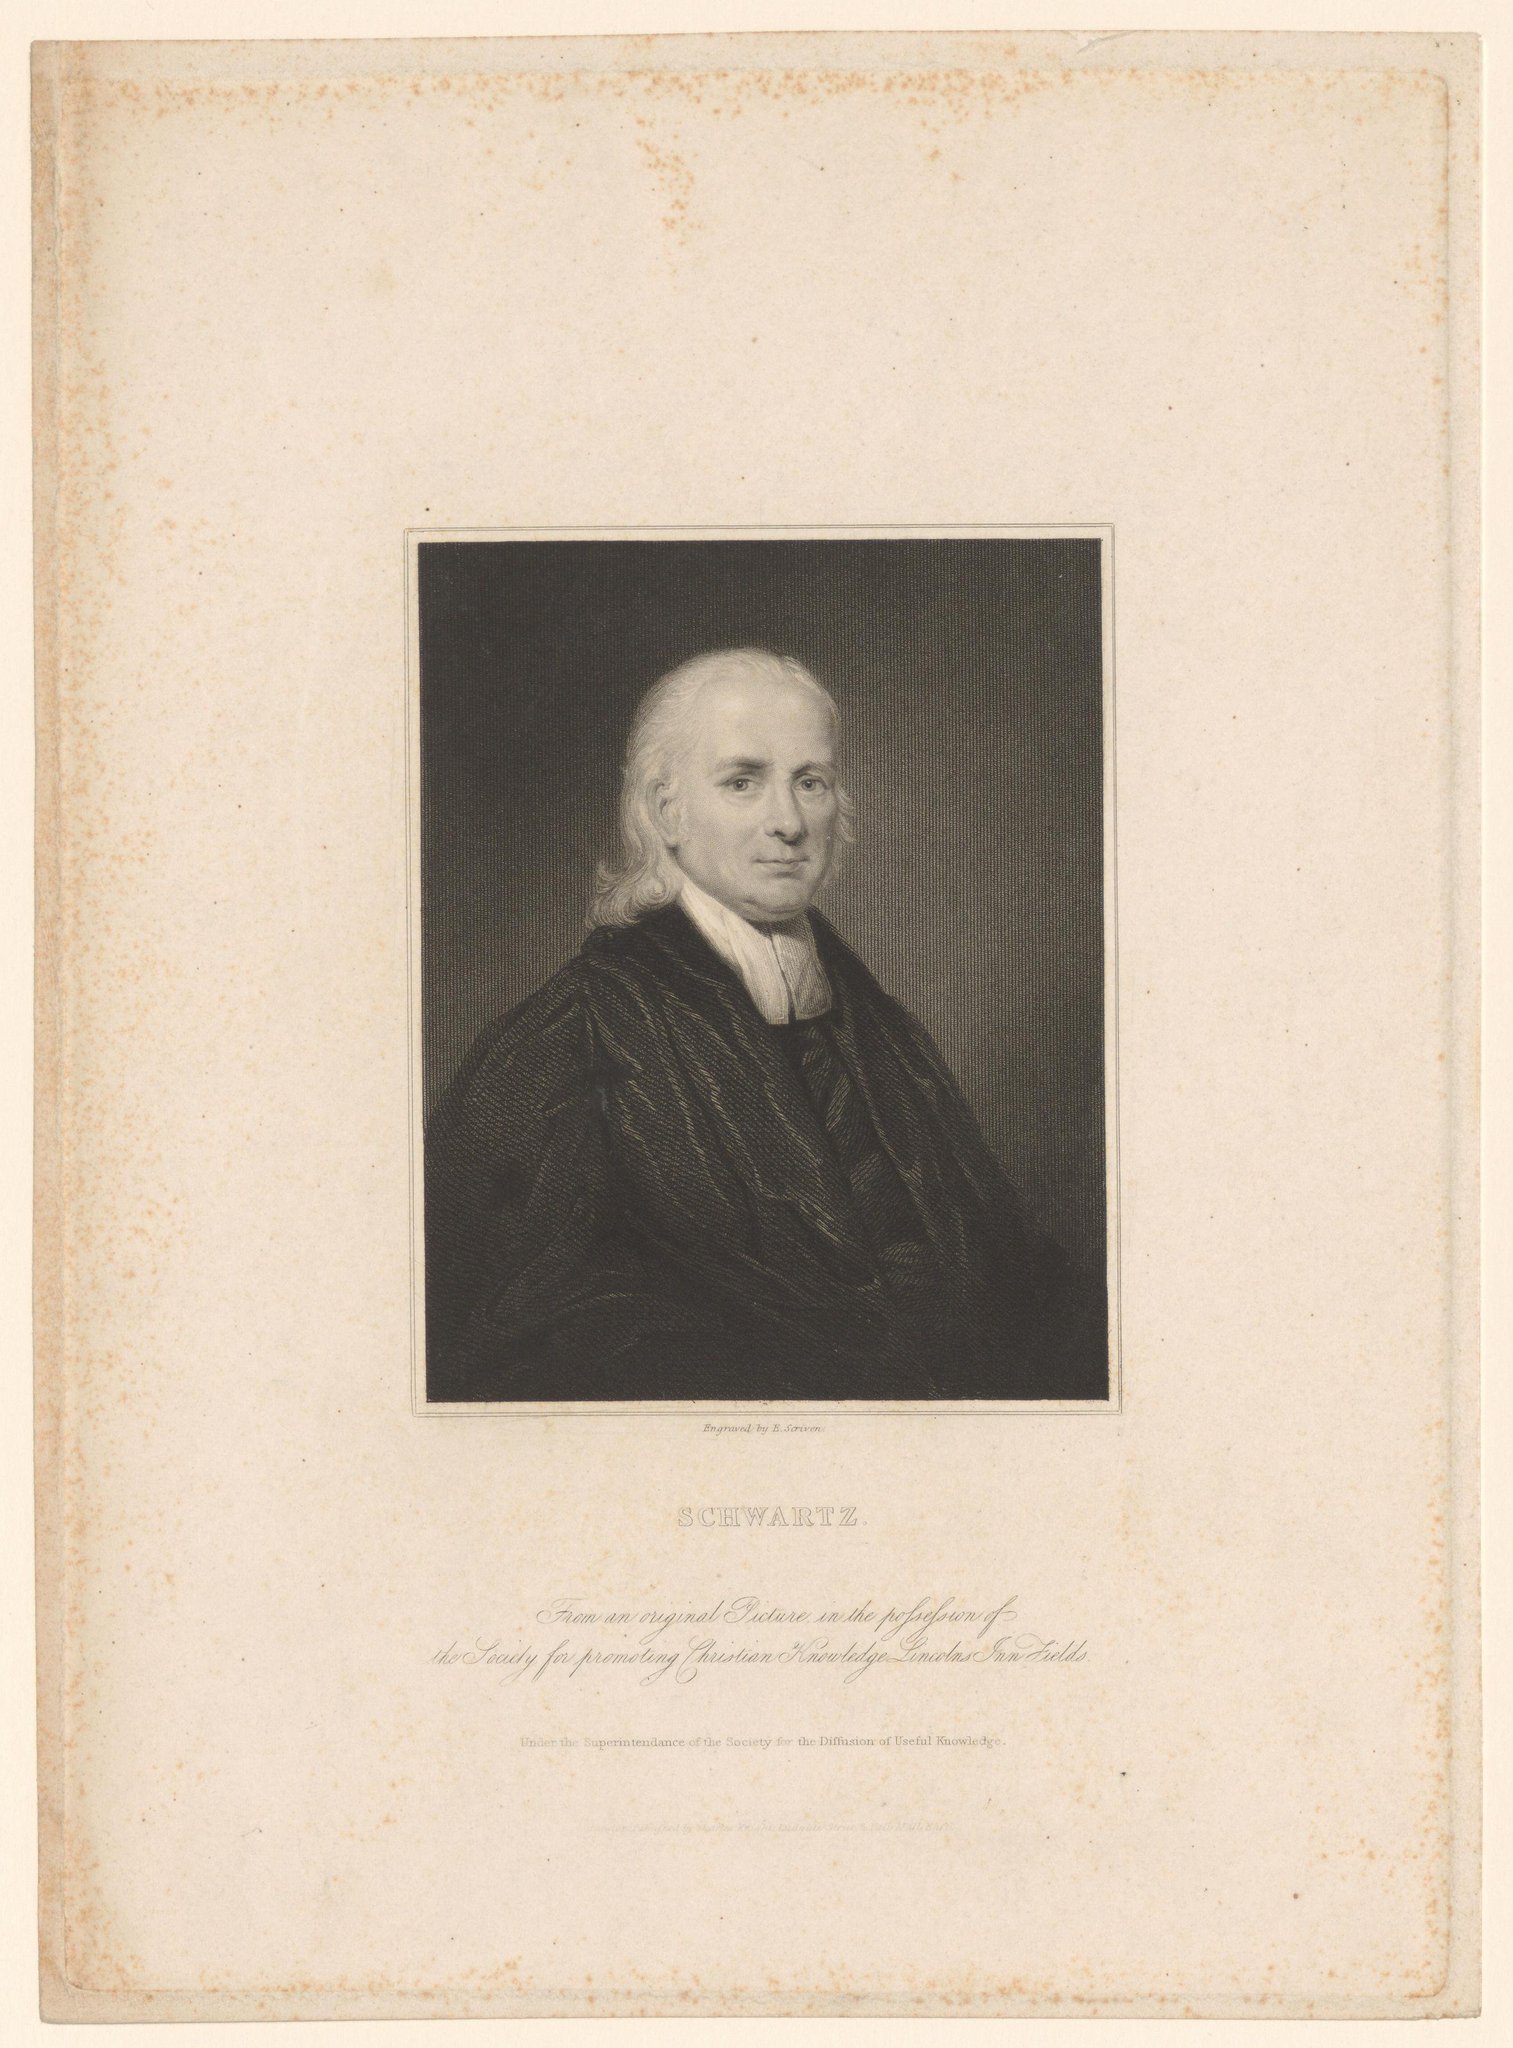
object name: print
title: Schwartz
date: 1827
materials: paper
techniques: etching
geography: london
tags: missionary, theologian, historical persons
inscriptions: collector's mark: Lugt 2228